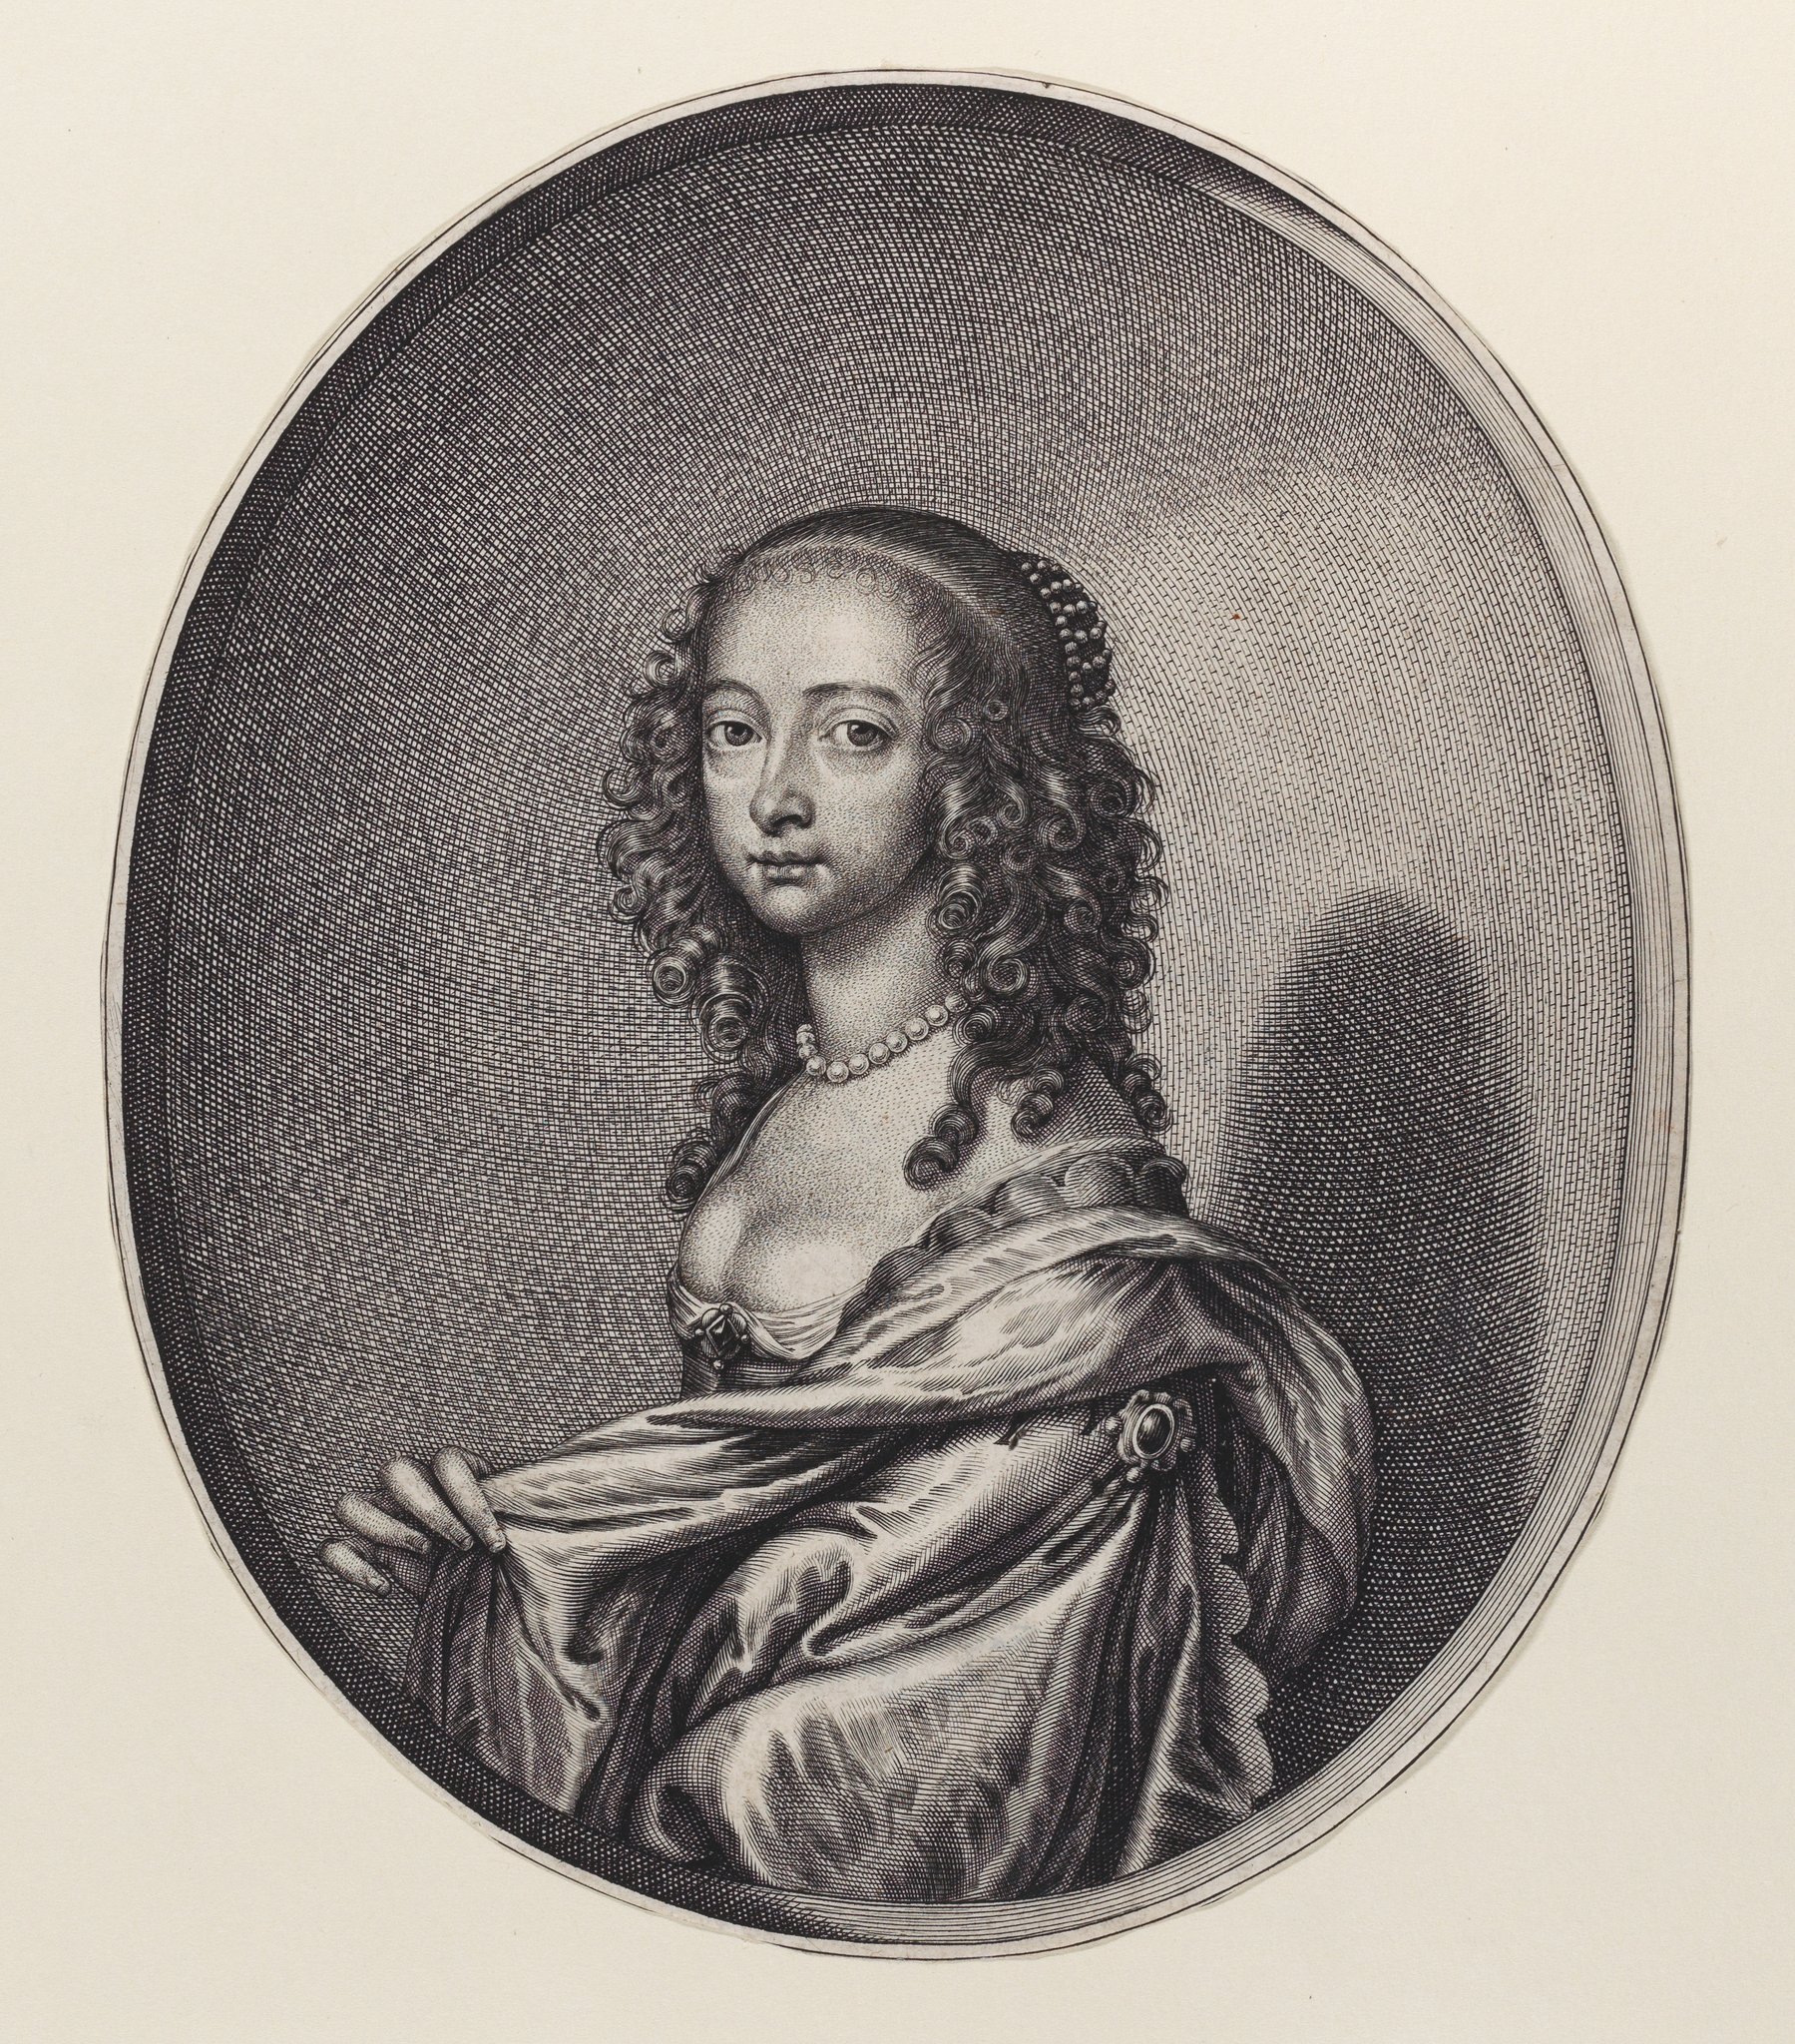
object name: print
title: Mary, Princess of Orange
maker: william faithorne the elder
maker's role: engraver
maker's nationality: british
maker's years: 1615-1691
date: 1641-1650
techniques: engraving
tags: princesses,portraits,women